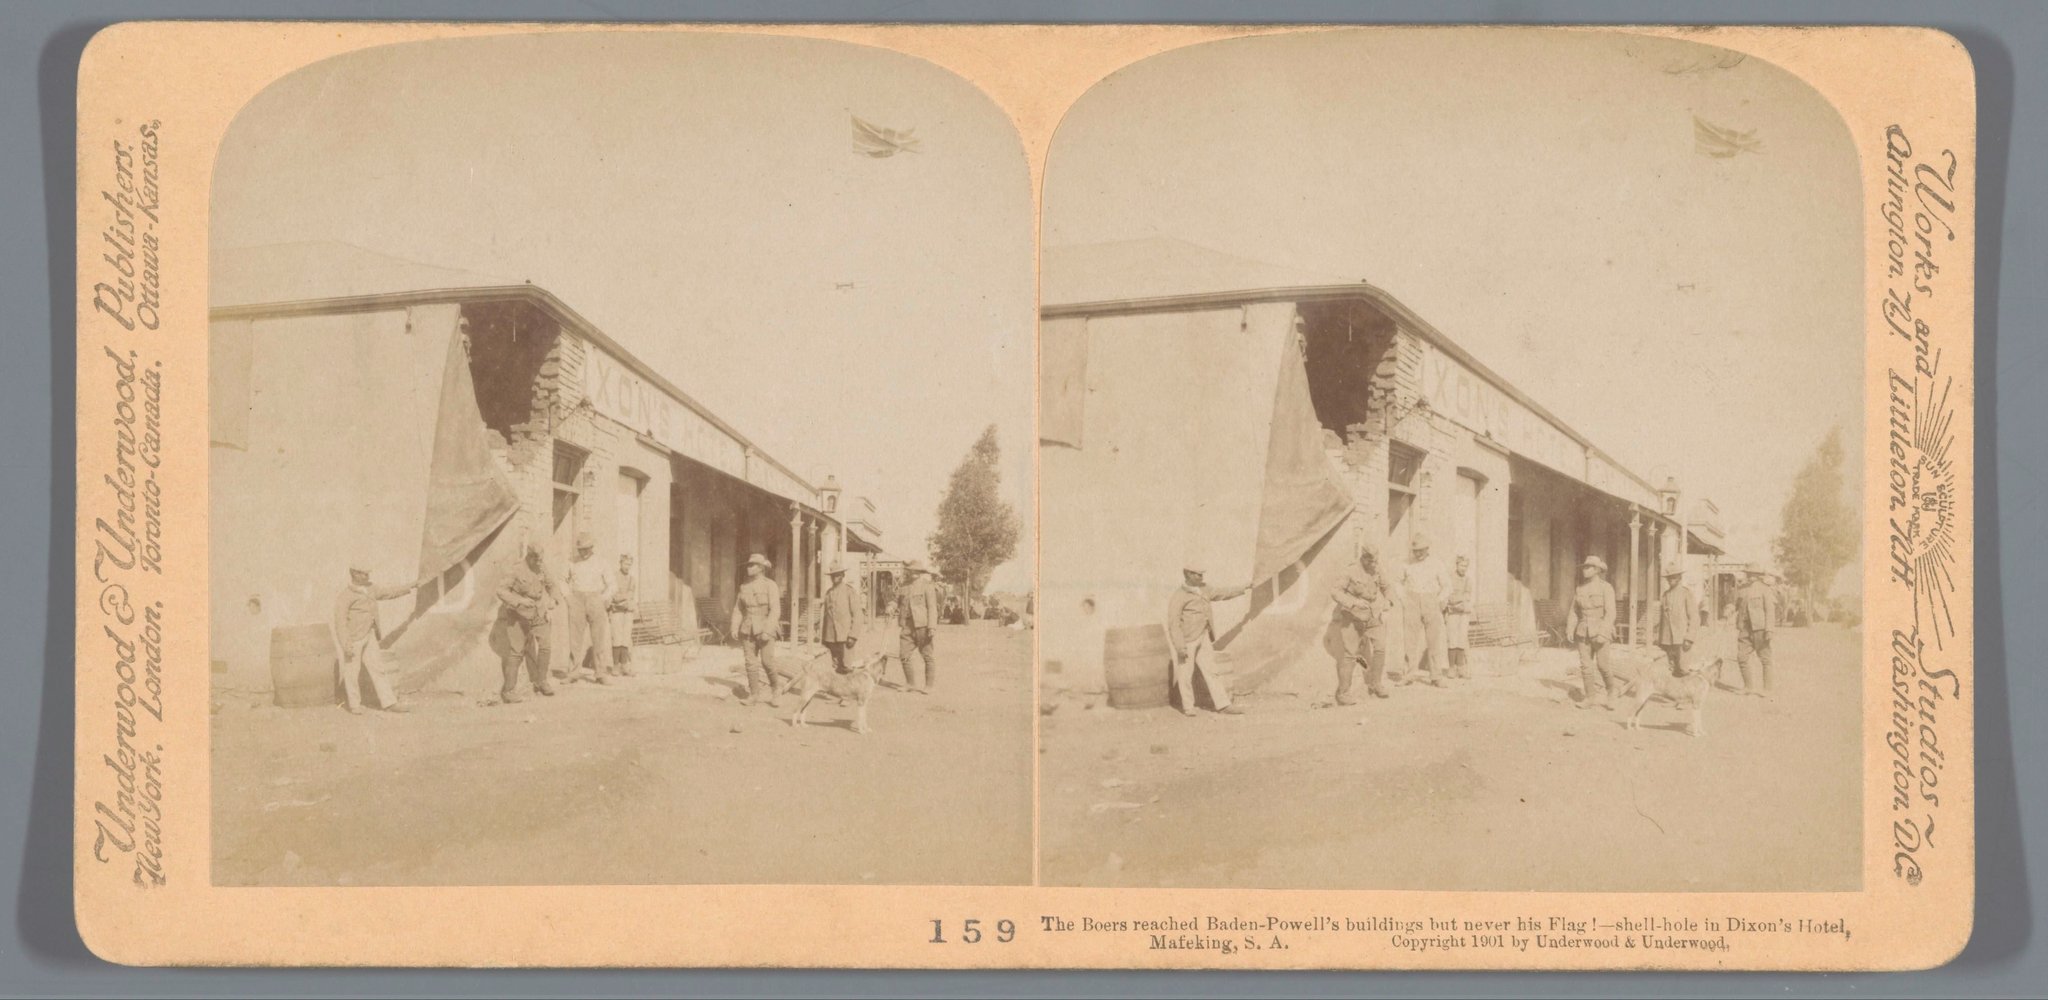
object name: stereograph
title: Gezicht op het beschadigde Dixon hotel, het hoofdkwartier van Robert Baden-Powell in Mafeking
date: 1901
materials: cardboard, photographic support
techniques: albumen print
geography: mafeking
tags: demolishing (of conquered city)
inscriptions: name: ‘Works and Studios Sun Sculpture trade mark Arlington N.J. Littleton N.H. Washington D.C.’, number: ‘159’